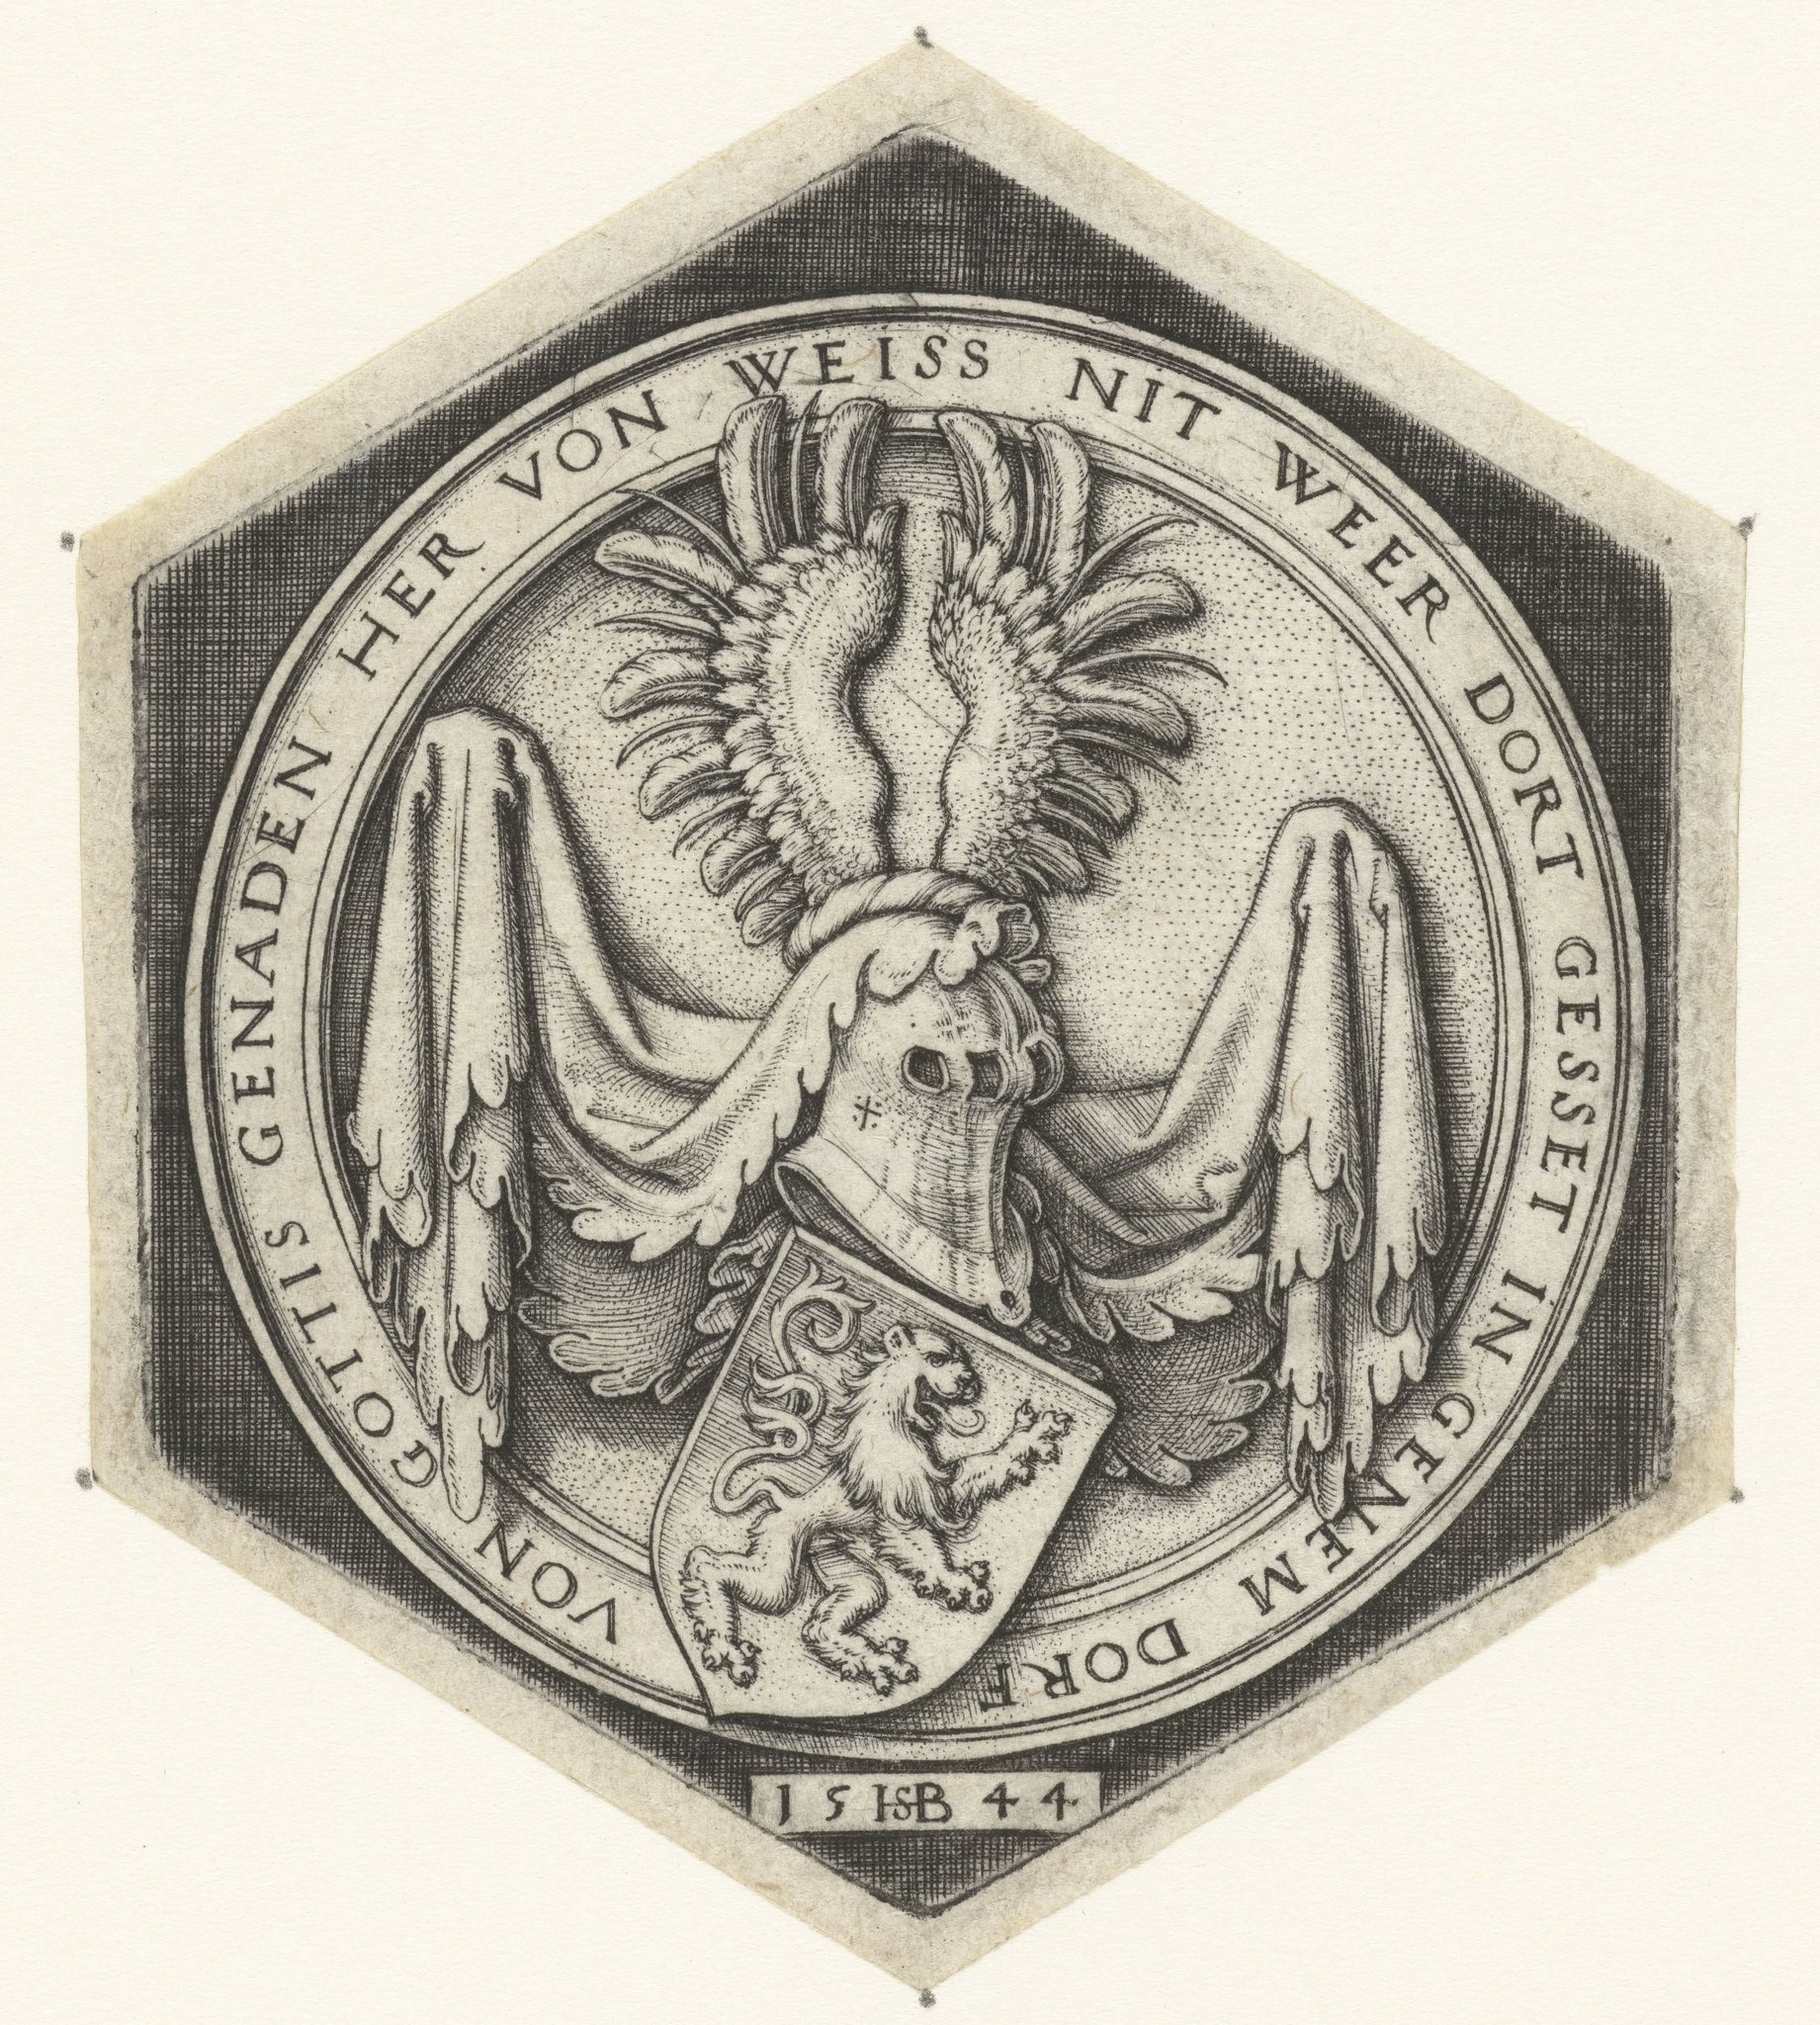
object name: print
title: Wapen met een klimmende leeuw op een schild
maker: hans sebald beham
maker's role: designer, draughtsman, print maker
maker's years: 1500-1550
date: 1544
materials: paper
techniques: engraving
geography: frankfurt am main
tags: urban life, beasts of prey, predatory animals: lion (+ heraldic animals)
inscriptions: collector's mark: Lugt 2228a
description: Wapen met een klimmende leeuw op een schild met een fantasietekst in een rondschrift: VON GOTTES GENADEN HER VON WEISS NIT WEER DORT GESSET IN GENEM DORF